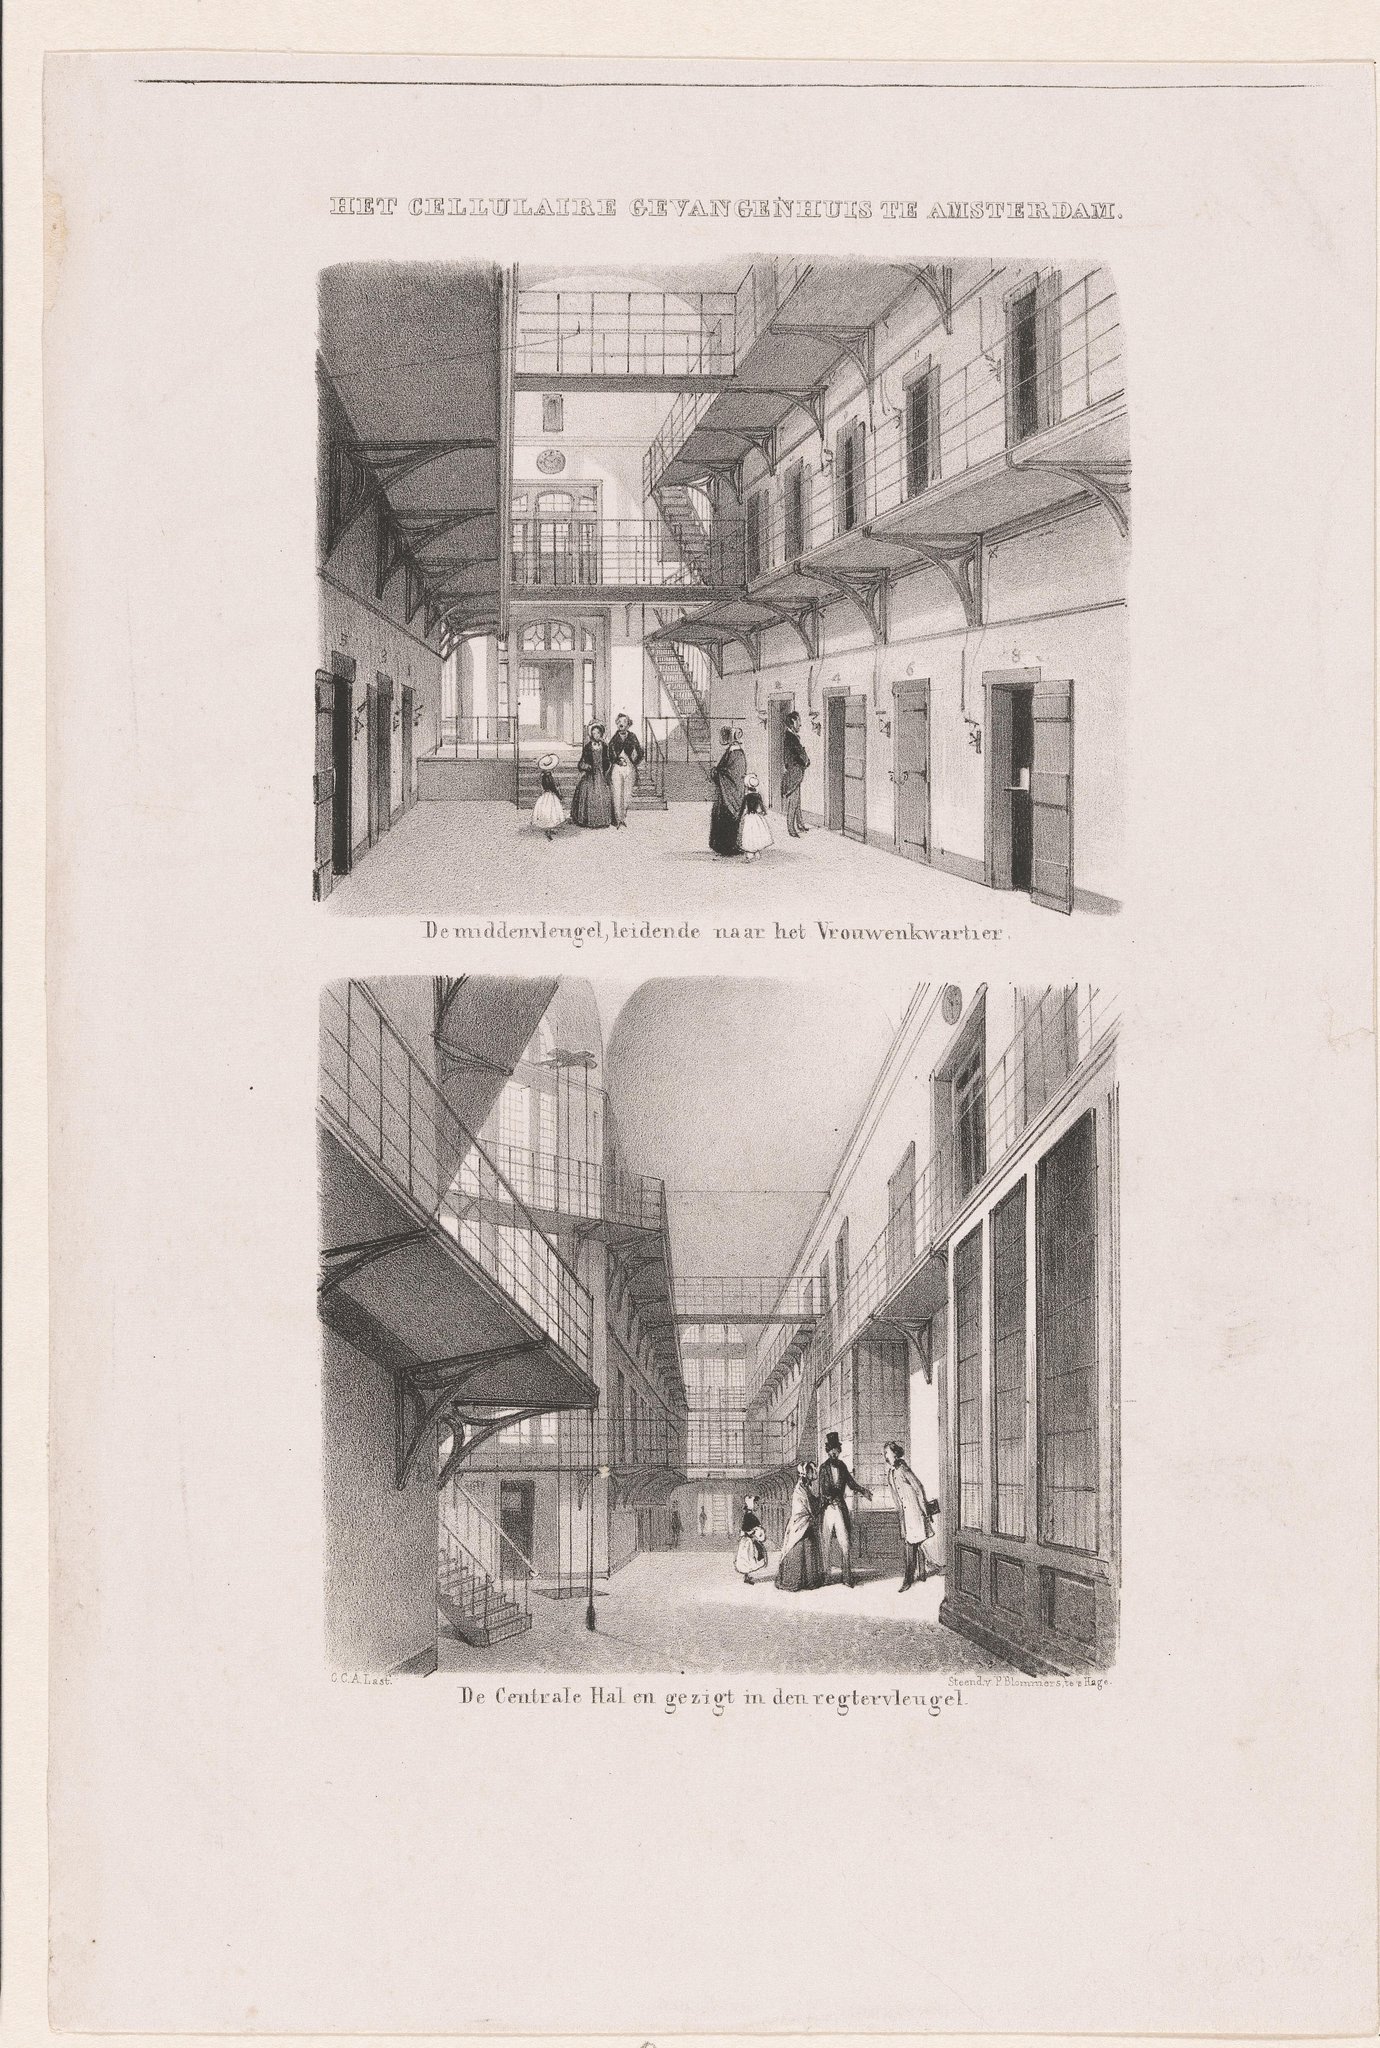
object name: book illustration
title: Interieur van de gevangenis aan de Weteringschans te Amsterdam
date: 1847-1848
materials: paper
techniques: lithograph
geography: netherlands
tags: prison, jail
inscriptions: collector's mark: Lugt 2228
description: Twee gezichten binnen in het net voltooide Huis van Bewaring aan de Weteringschans te Amsterdam, 1848. Boven de middenvleugel leidend naar het vrouwenkwartier, onder de centrale hal in de rechtervleugel. Zie ook de pendant.